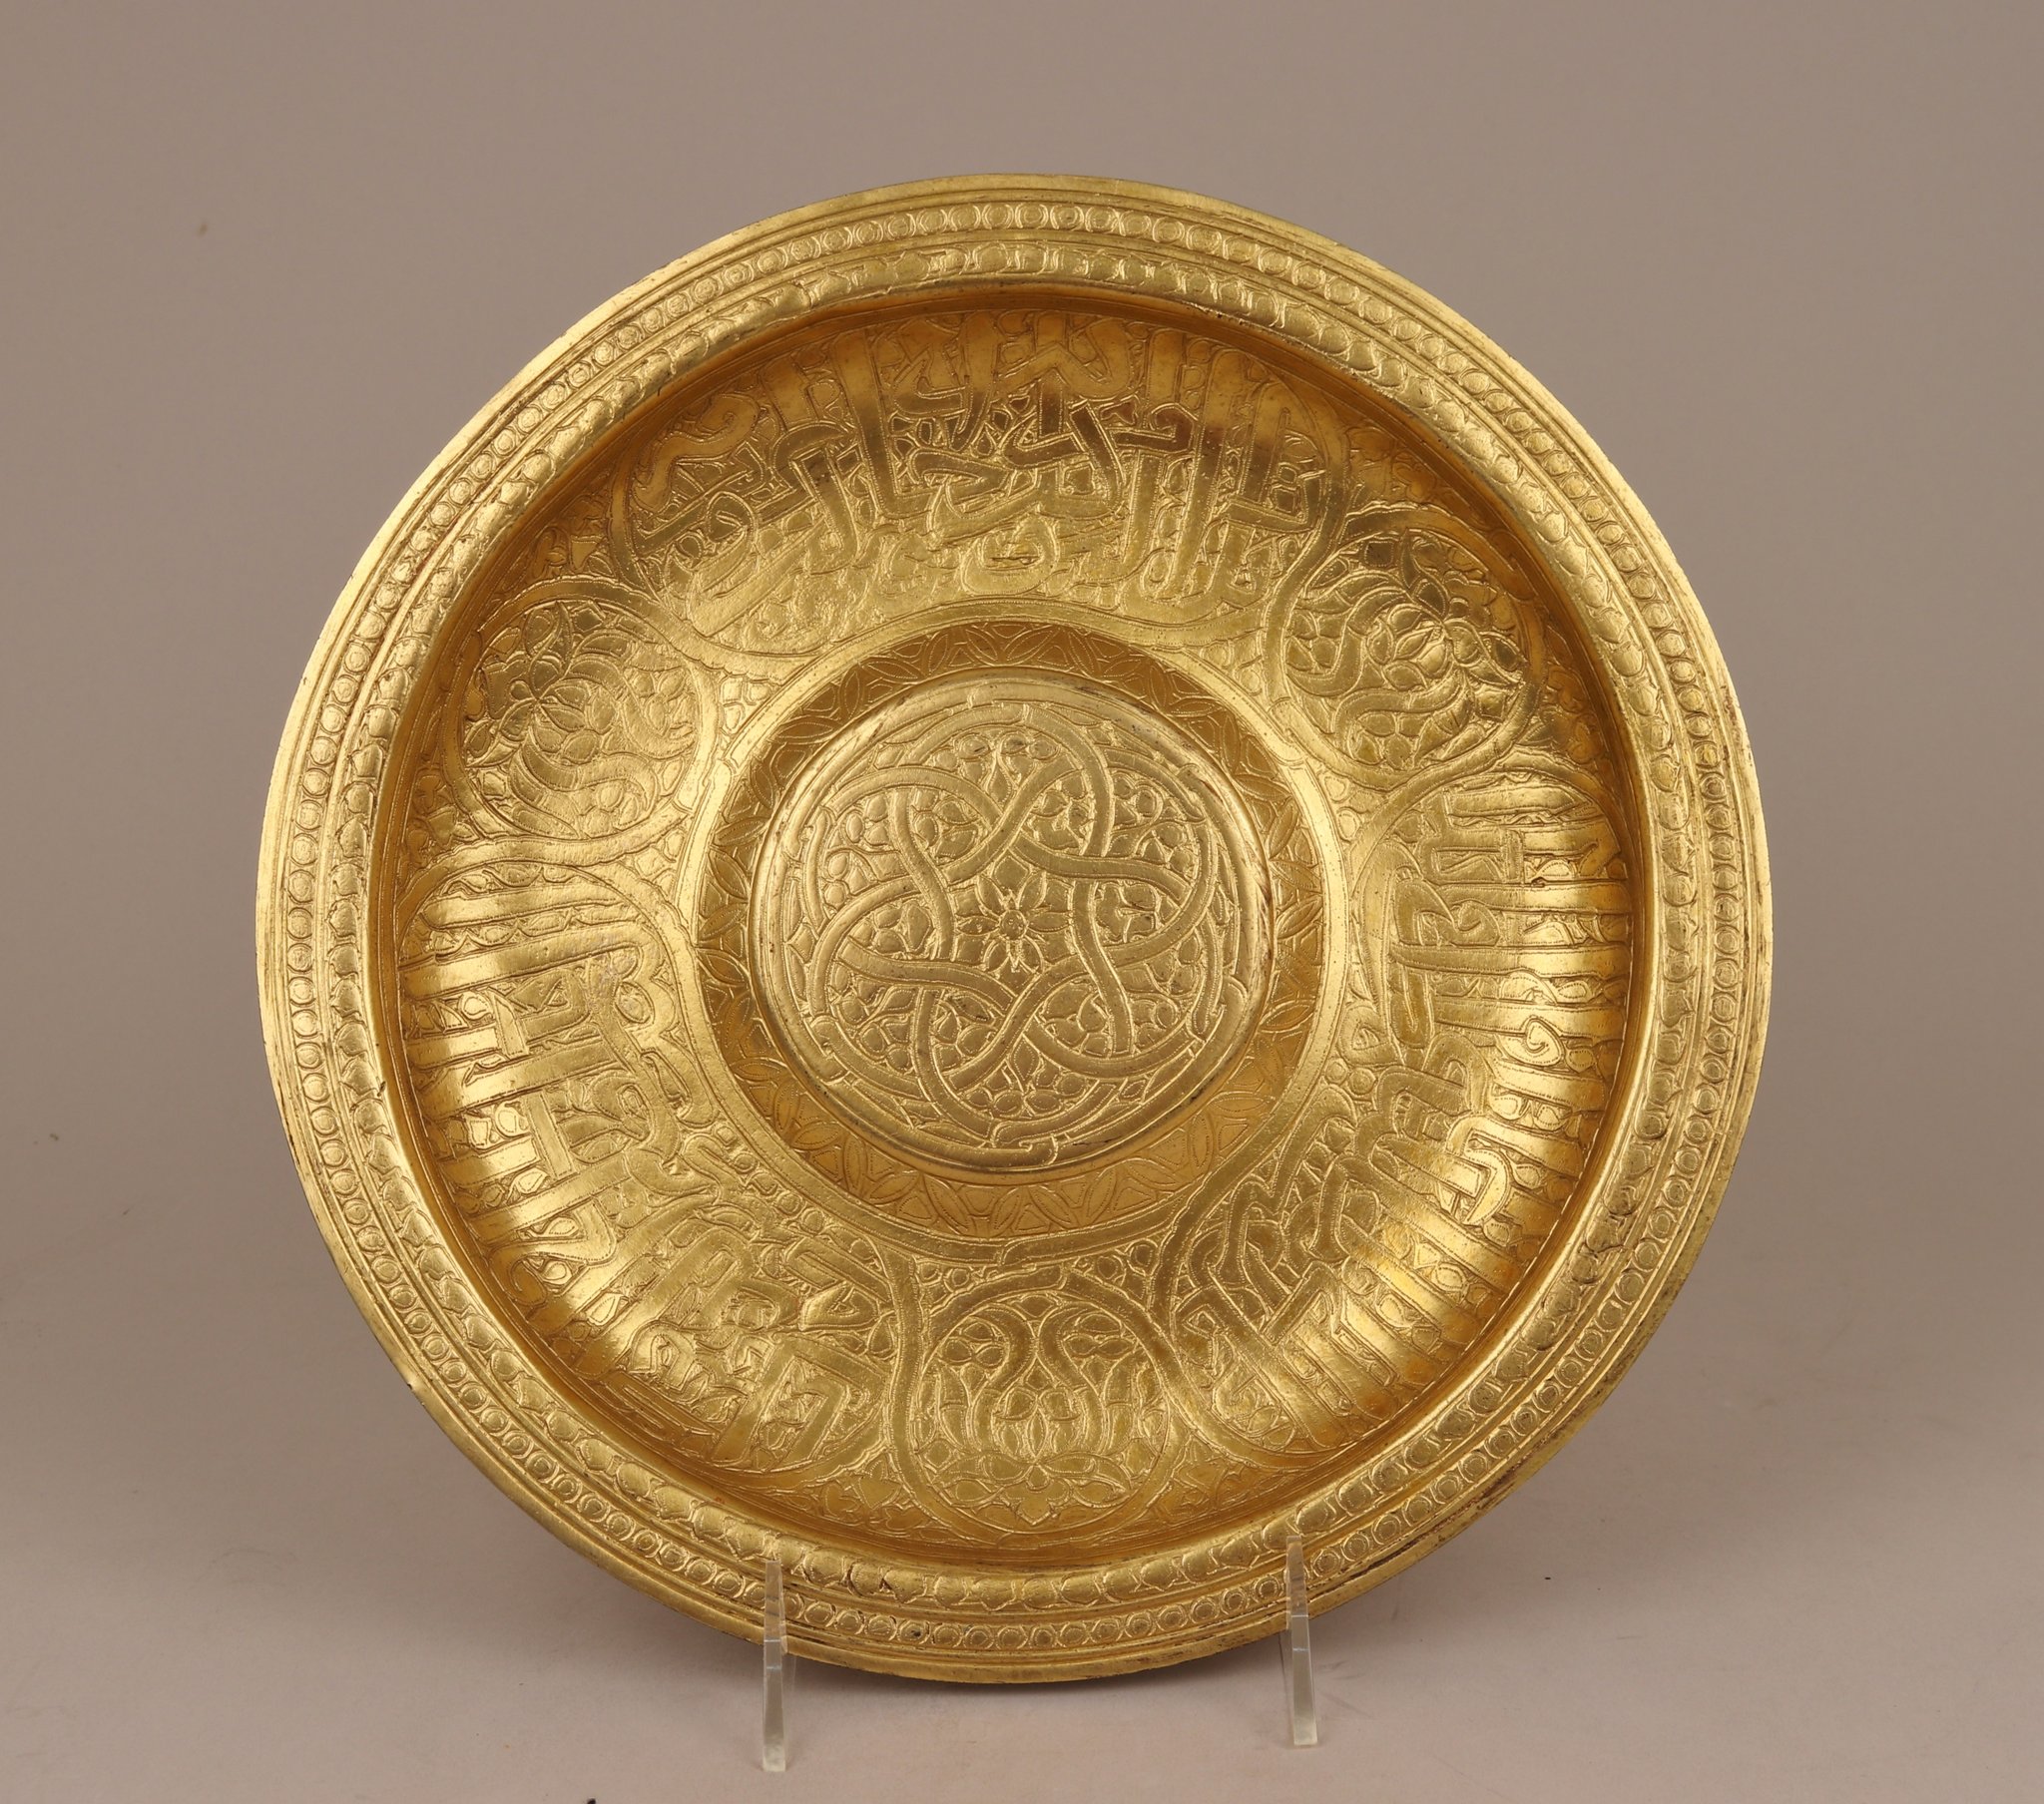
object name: bowl or plateau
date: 1801-1900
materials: brass